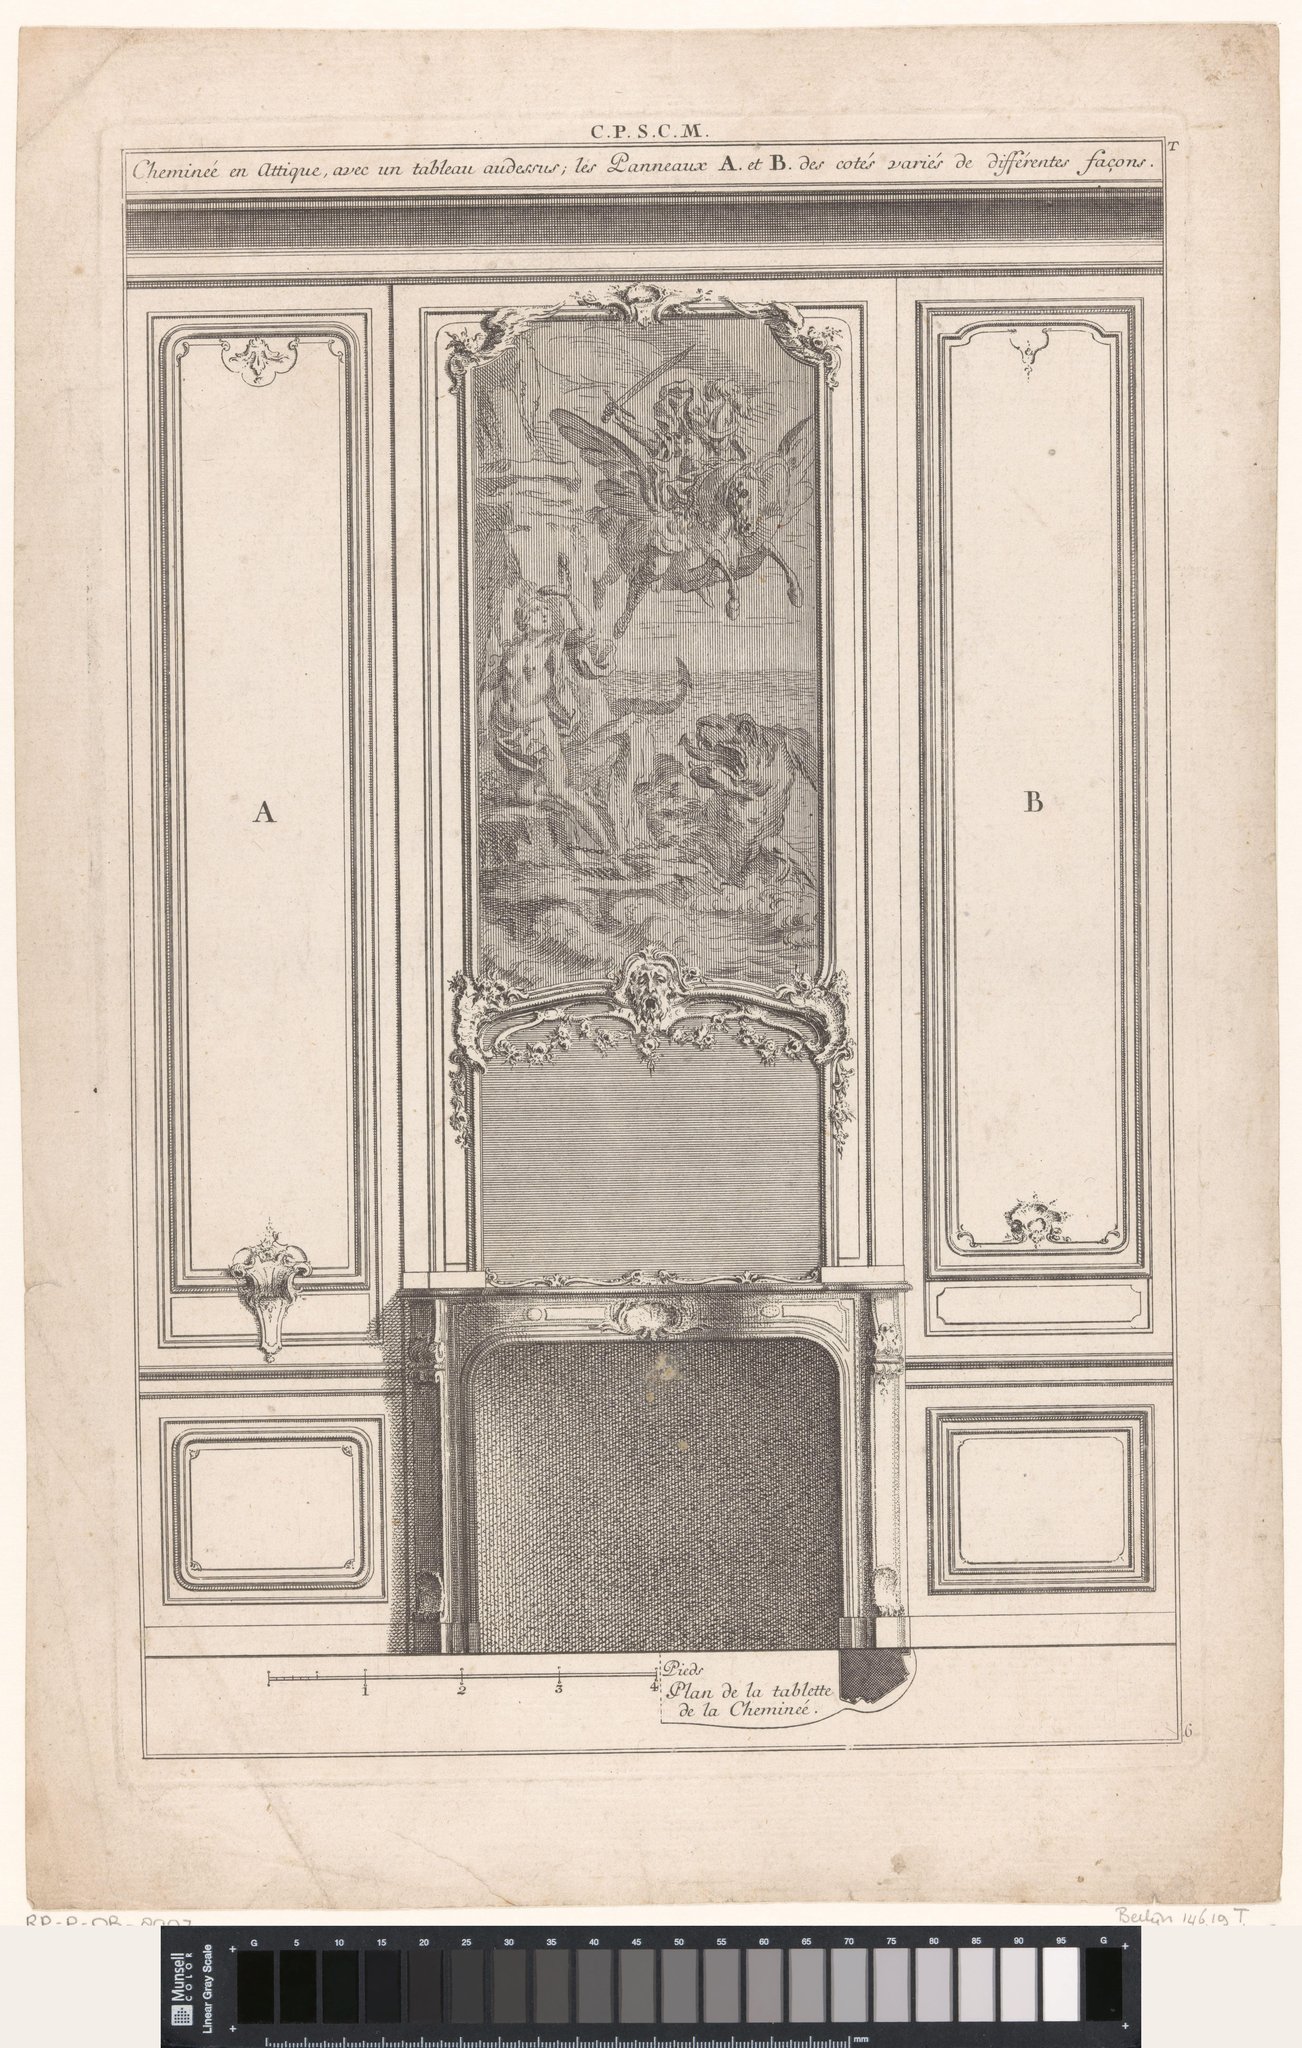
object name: ornament print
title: Wanddecoraties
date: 1745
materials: paper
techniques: engraving, etching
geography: paris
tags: open hearth, fire-place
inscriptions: collector's mark: Lugt 2228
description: Een geornamenteerde schouw met daarboven een paneel met Andromeda en Perseus.